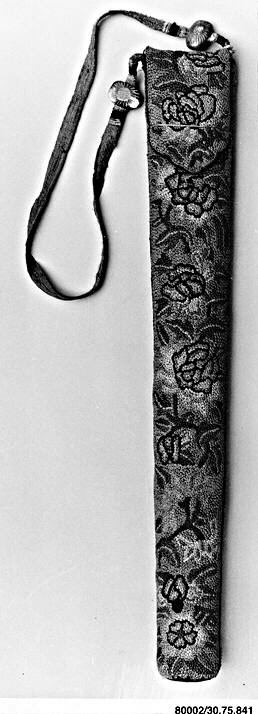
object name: fan holder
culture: chinese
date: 1701-1900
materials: silk